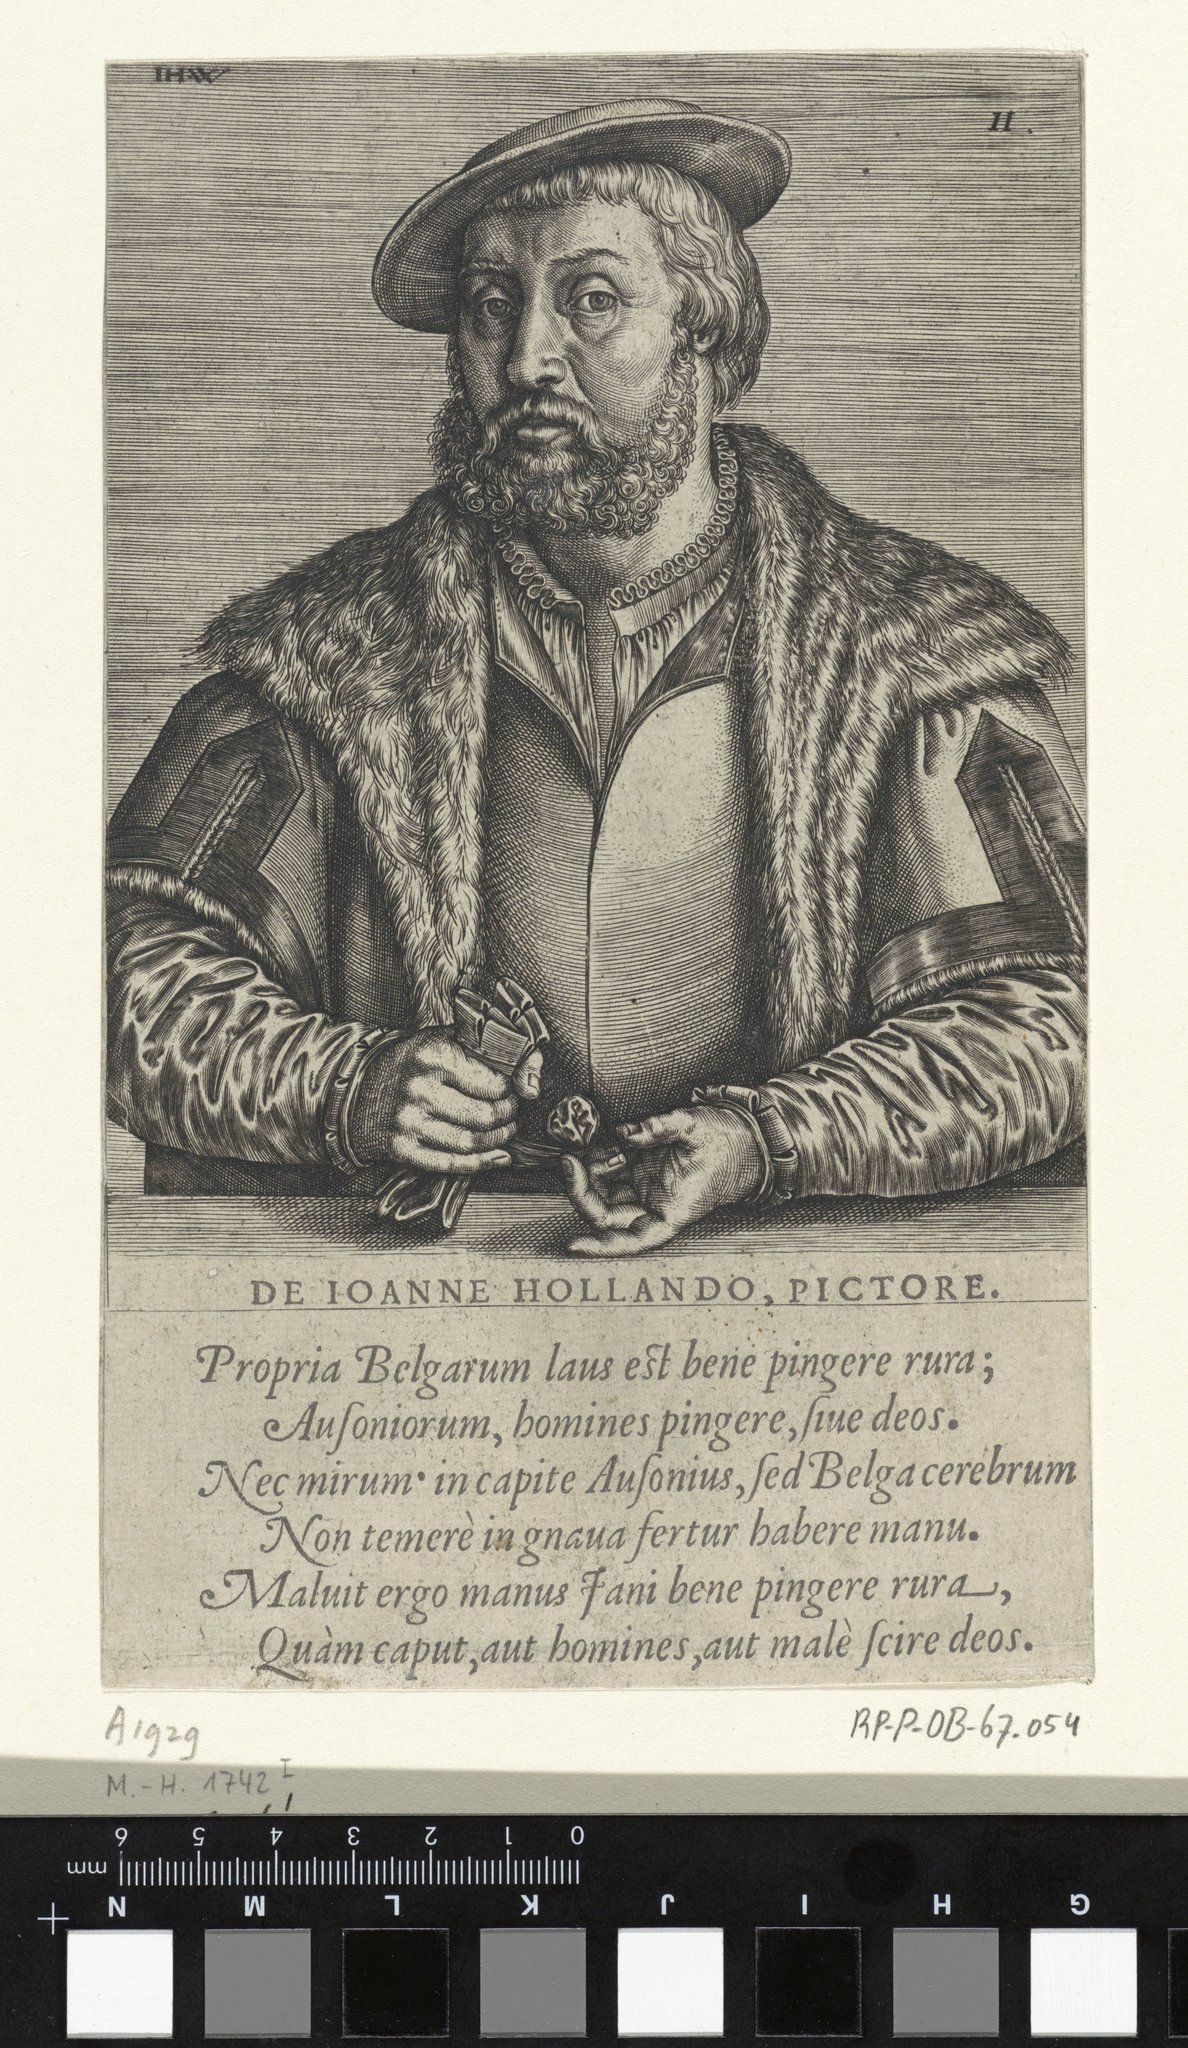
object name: print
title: Portret van de schilder Jan van Amstel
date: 1572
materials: paper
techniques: engraving, letterpress printing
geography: antwerp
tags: amsterdam, antwerp, painter, draughtsman, portrait, self-portrait of painter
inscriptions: collector's mark: Lugt 2165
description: In de marge een zesregelig onderschrift in het Latijn.